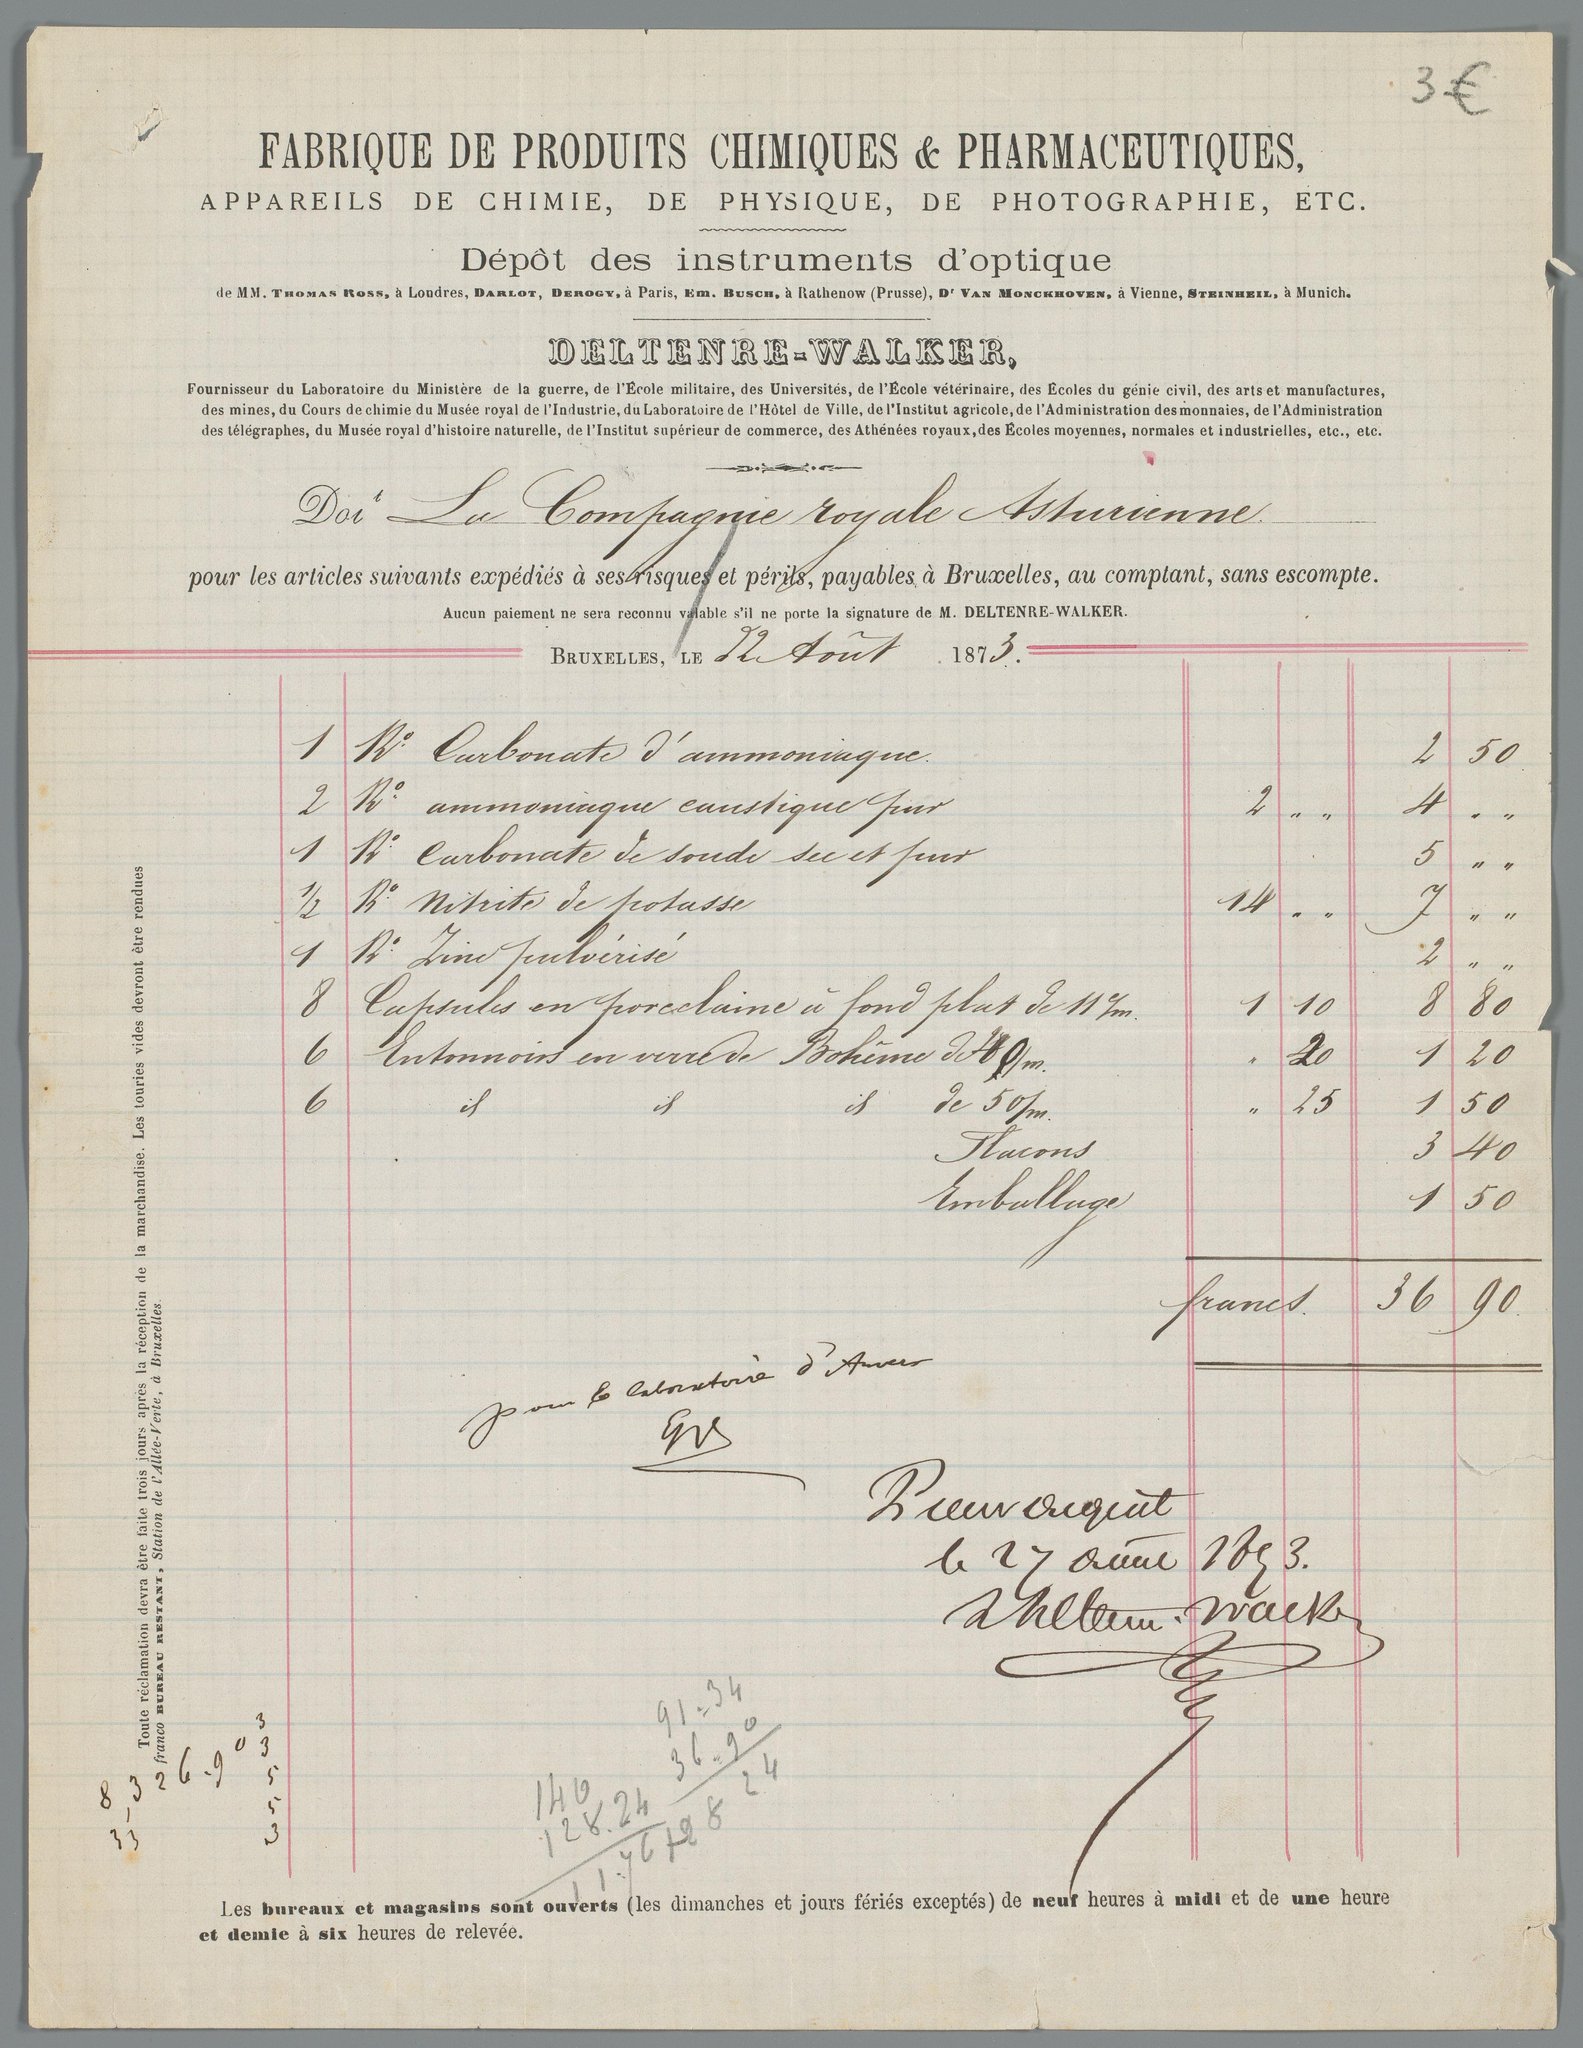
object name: account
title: Rekening van de firma Deltendre-Walker gericht aan de Compagnie royale asturienne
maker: léon deltenre-walker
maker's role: fotograaf, handelaar, redacteur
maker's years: 1819-1881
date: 1873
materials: ink, paper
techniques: pen, printing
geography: brussels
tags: photography, cheque, draft, bill of exchange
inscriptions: inscription: ‘[...]’, inscription: ‘3€’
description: Rekening van de firma Deltendre-Walker gericht aan de Compagnie royale asturienne Anvers, gedateerd op 22 augustus 1873 te Brussel. De rekening bevat diverse artikelen met een totaalbedrag van 36,90 Belgische frank.